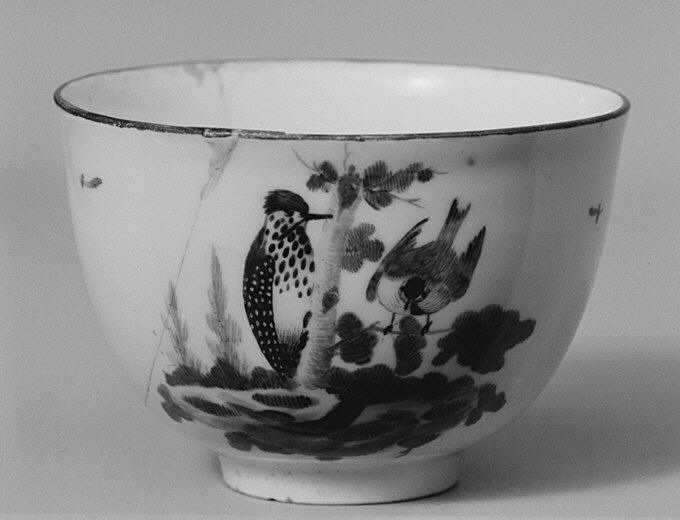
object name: cup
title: Cup (part of a service)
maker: frankenthal porcelain manufactory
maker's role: manufactory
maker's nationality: german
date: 1770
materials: hard paste porcelain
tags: birds